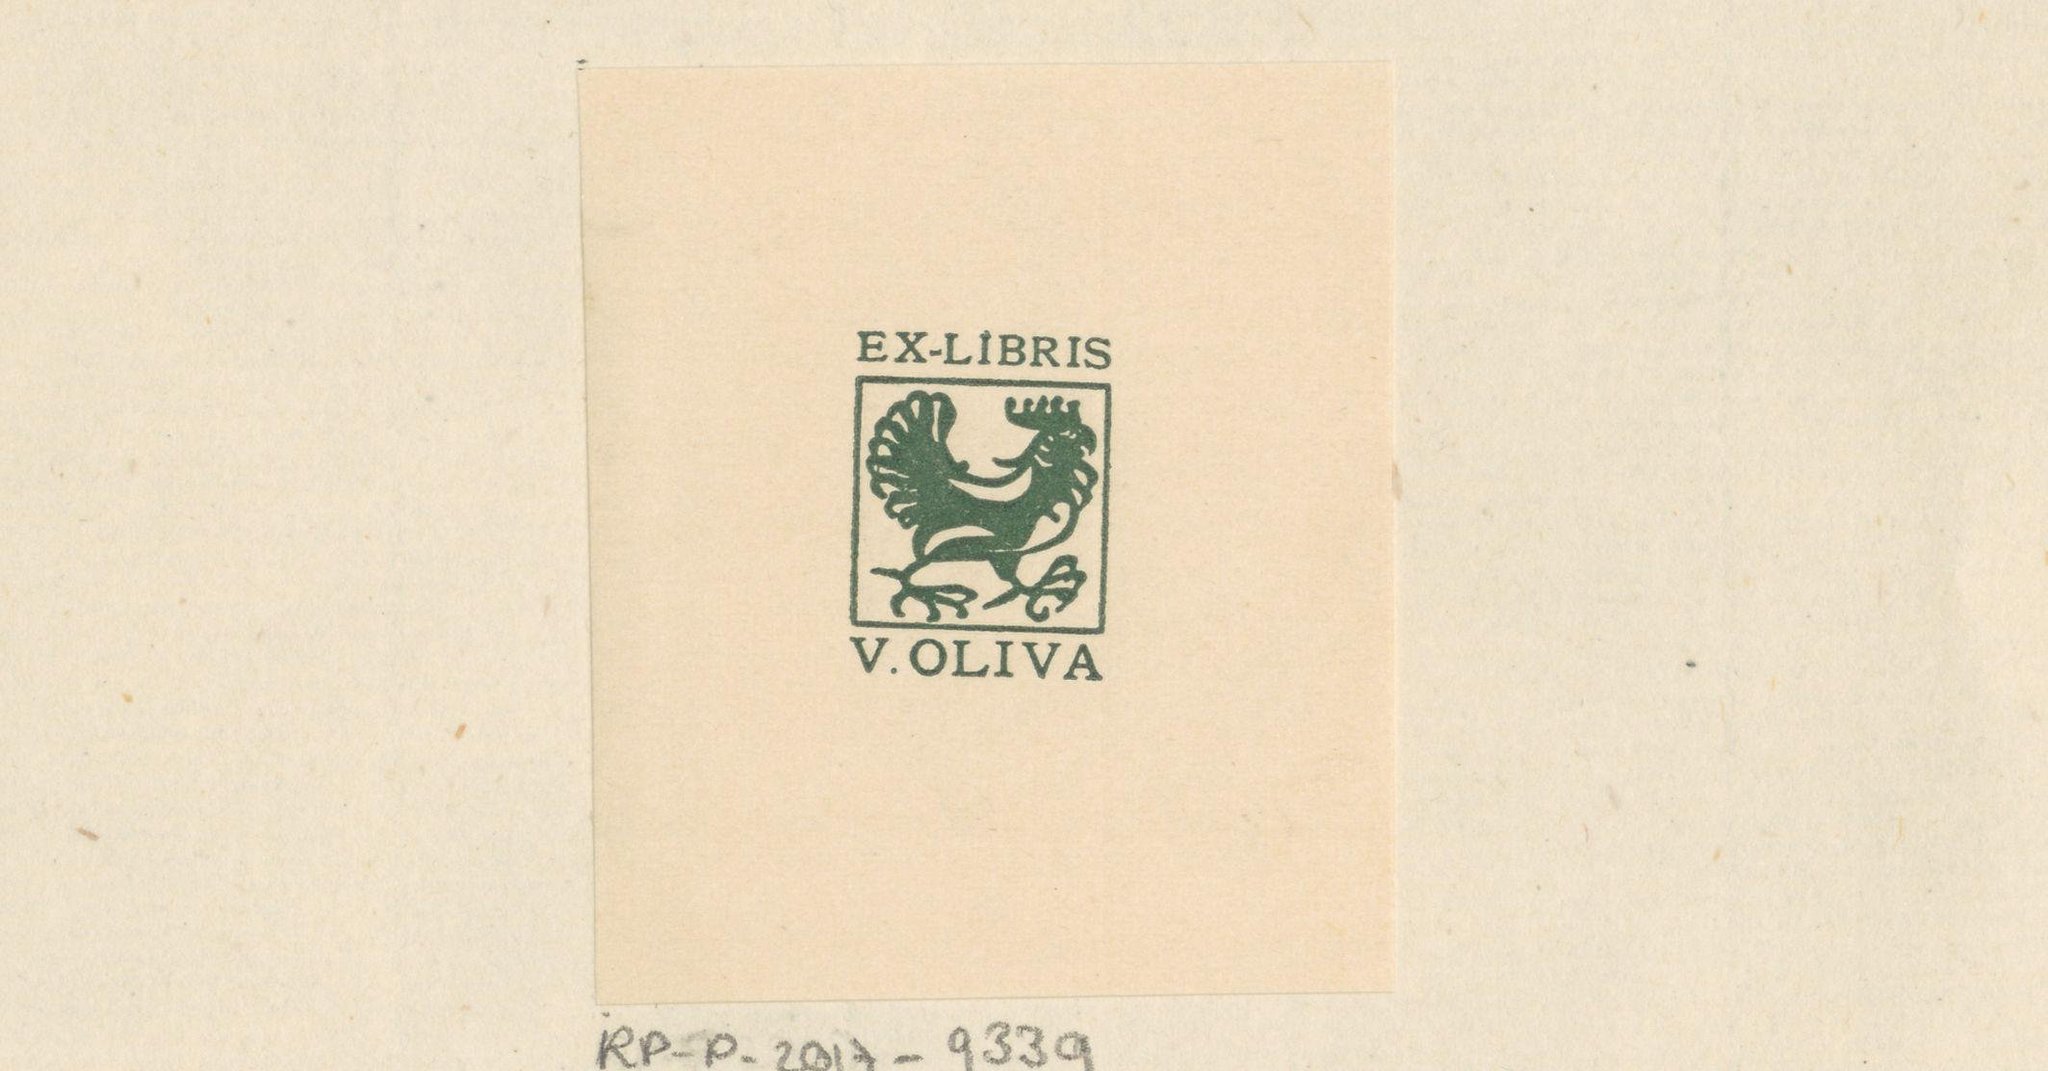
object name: bookplate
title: Ex libris van V. Oliva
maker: Anonymous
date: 1880-1949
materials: paper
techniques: printing block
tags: attributes of aesculapius